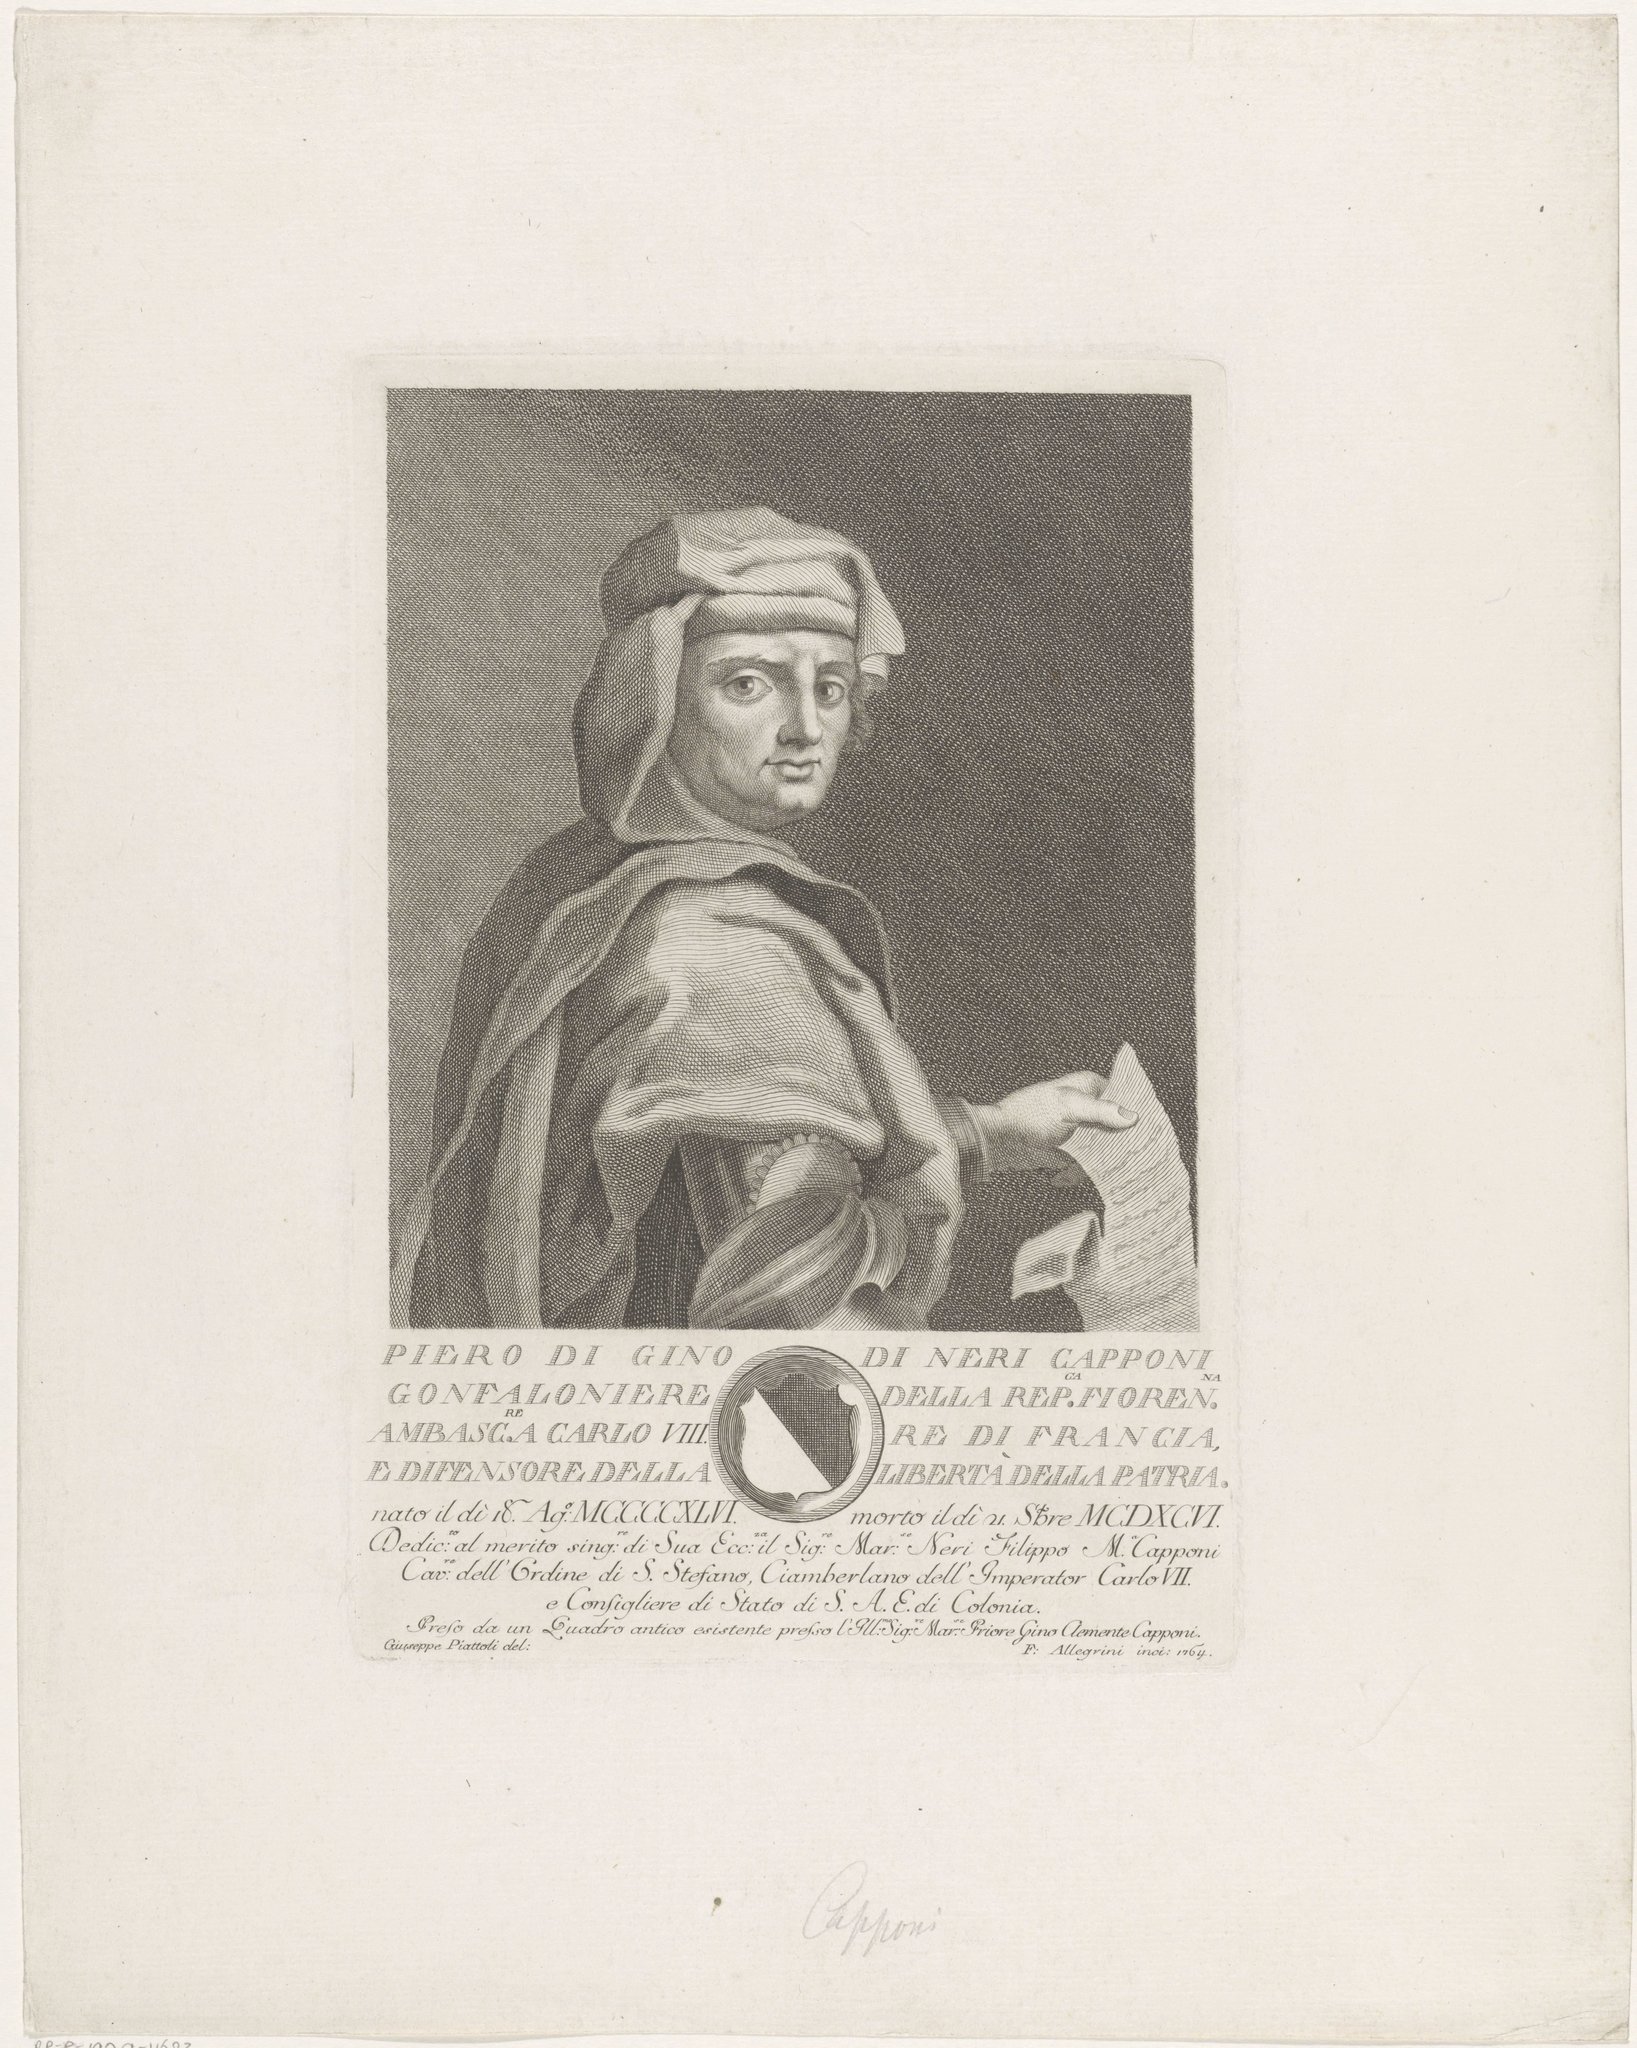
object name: print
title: Portretten van beroemde Italianen met wapenschild in ondermarge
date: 1764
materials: paper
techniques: engraving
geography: italy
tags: politician, historical persons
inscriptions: collector's mark: Lugt 2228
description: Deze prent maakt deel uit van een reeks portretprenten van onbekende omvang. De prenten zijn gemaakt door meedere prentmakers, onder wie Francesco Allegrini en Carlo en Raimondo Faucci.